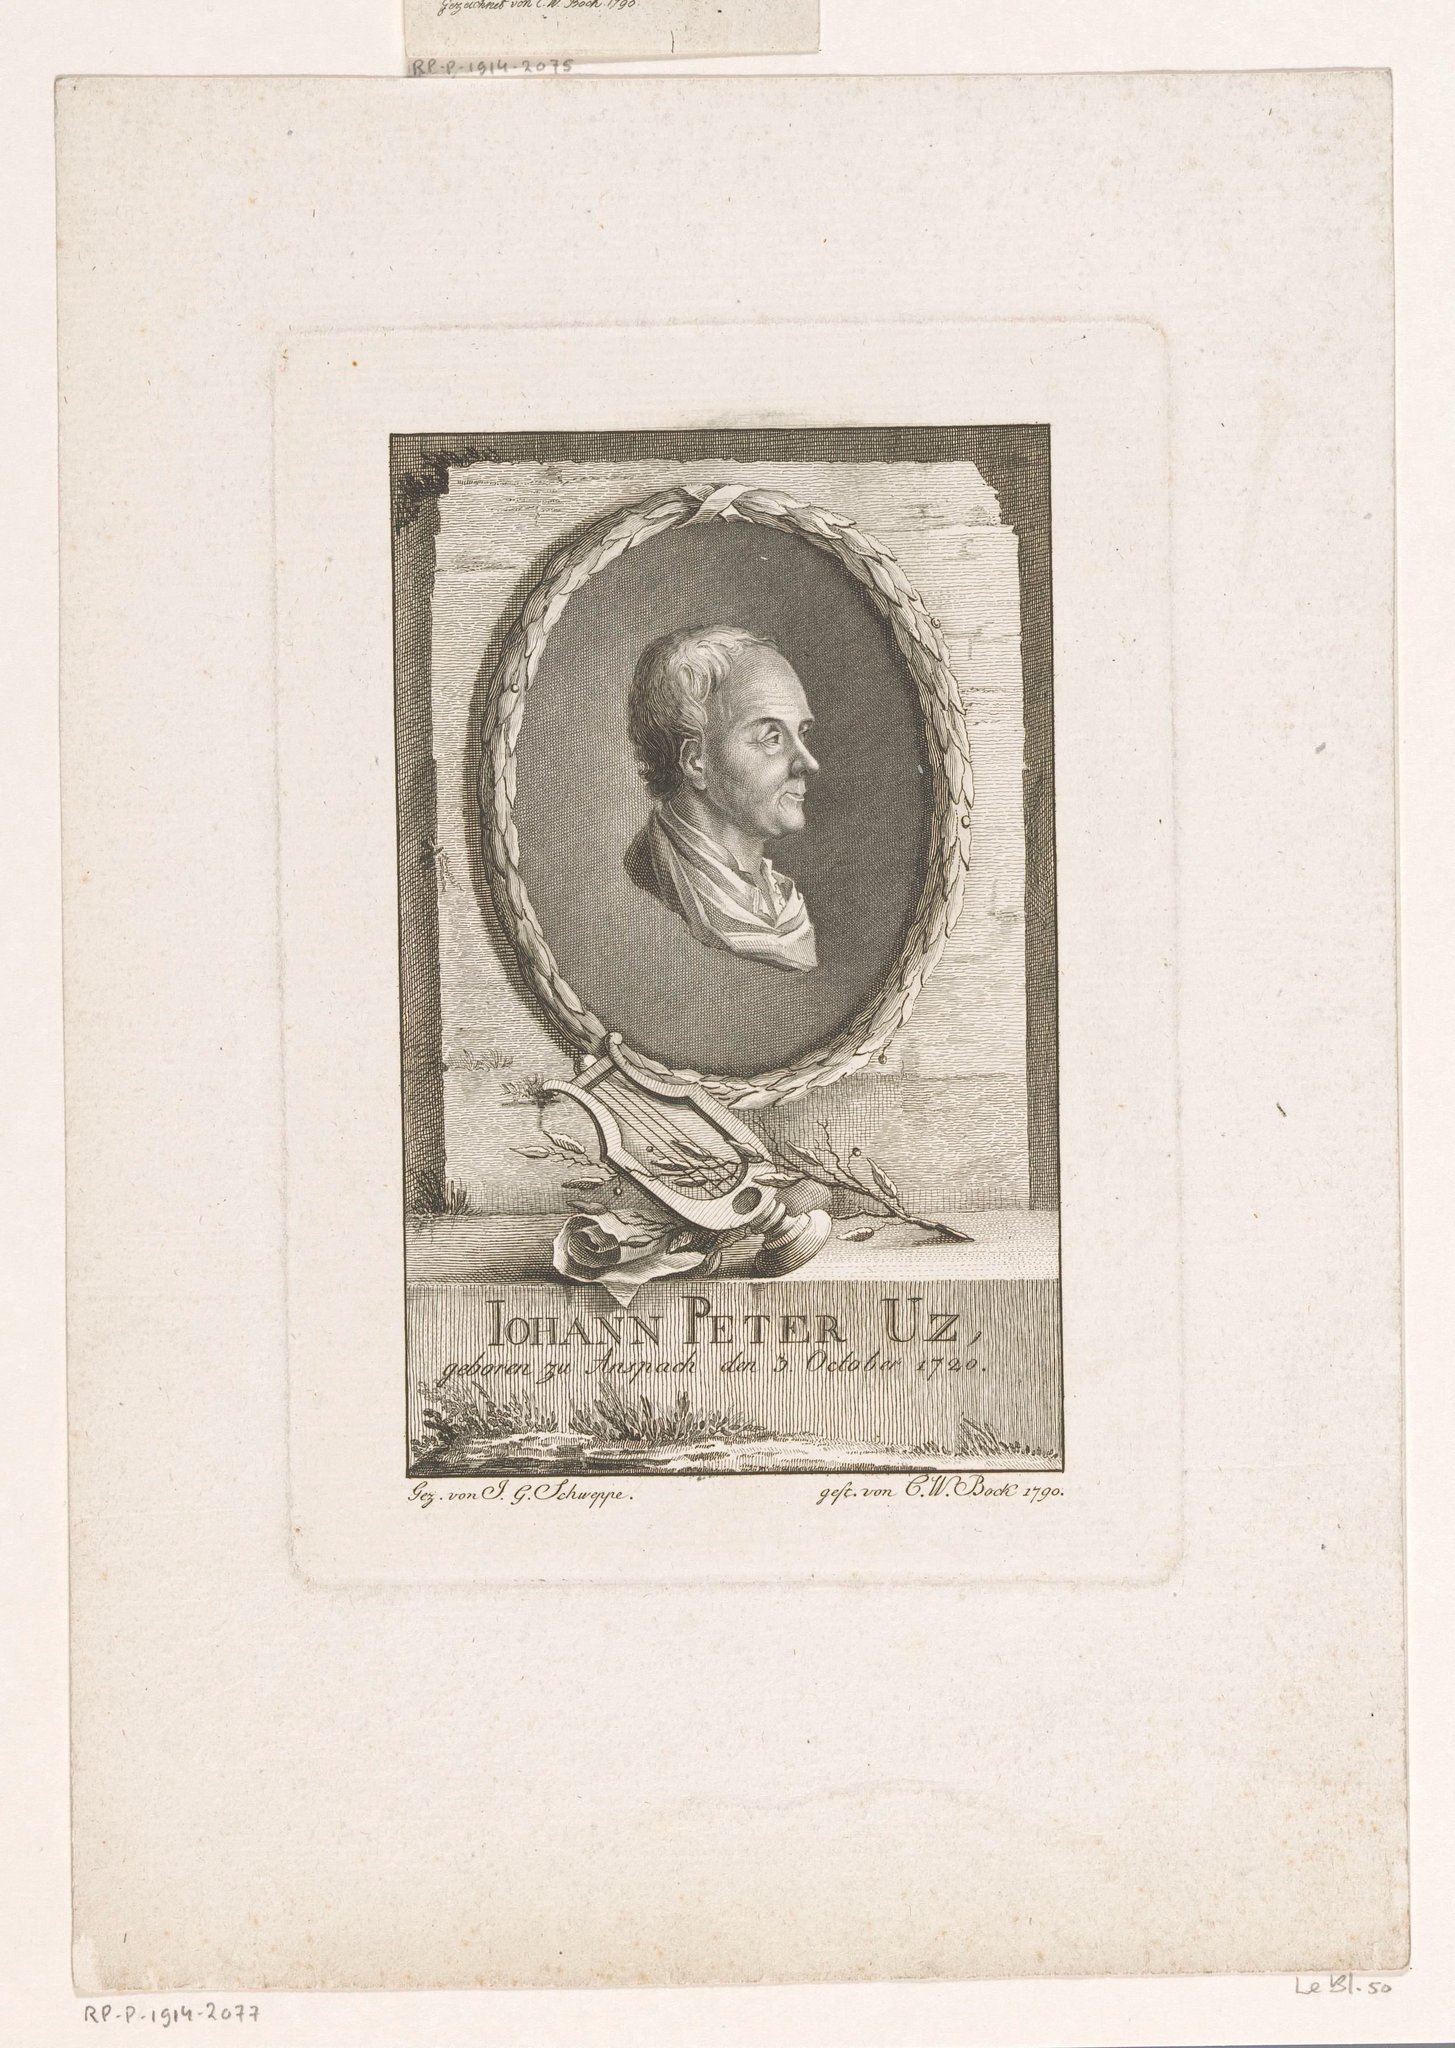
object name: print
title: Portret van Johann Peter Uz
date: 1790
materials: paper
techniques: engraving, etching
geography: nuremberg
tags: lyre, cithara, psaltery, historical persons, scroll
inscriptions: collector's mark: Lugt 2228